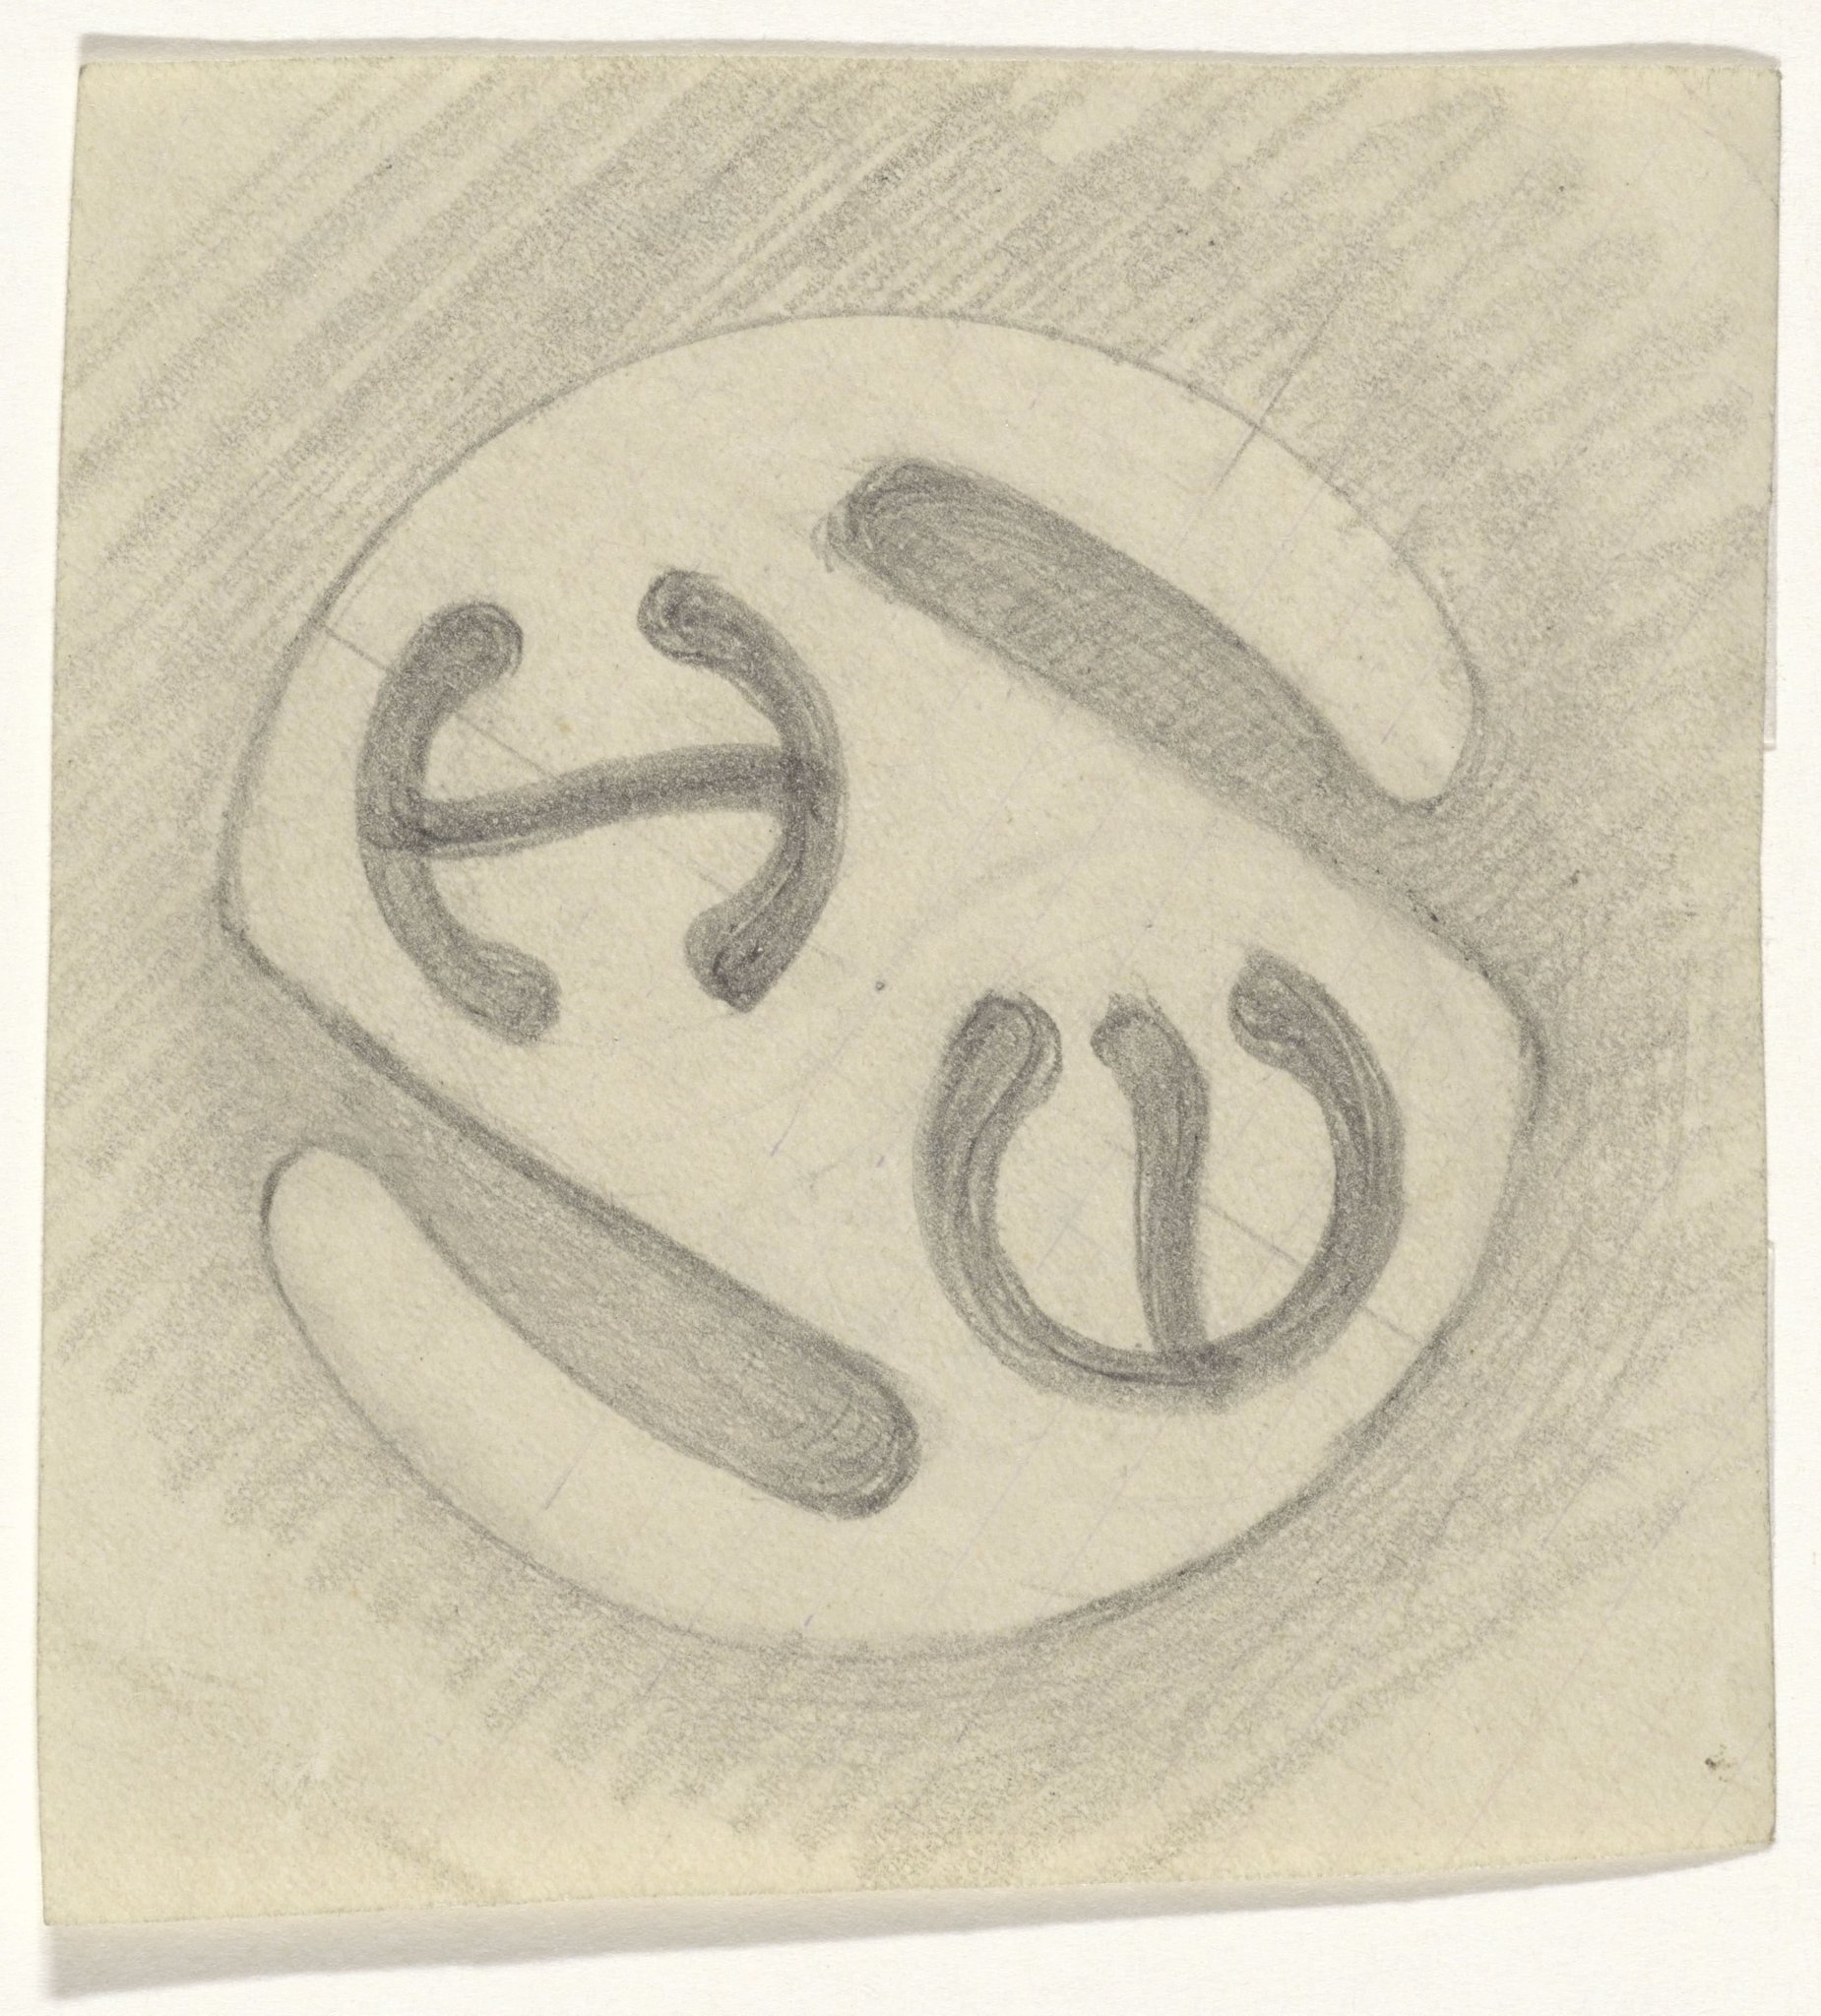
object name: drawing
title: Ontwerp voor een sieraad met de initialen H.S.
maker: mathieu lauweriks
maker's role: designer, draughtsman, print maker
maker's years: 1864-1932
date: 1874-1932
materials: pencil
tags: ornaments, jewels